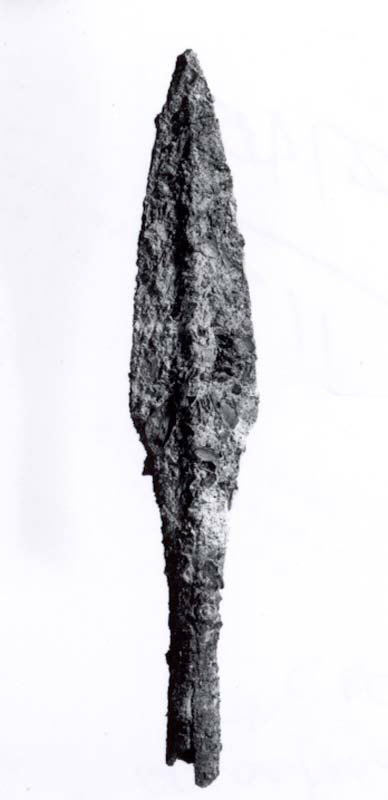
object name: spearhead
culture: iranian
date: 900-801 BCE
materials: iron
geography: iran